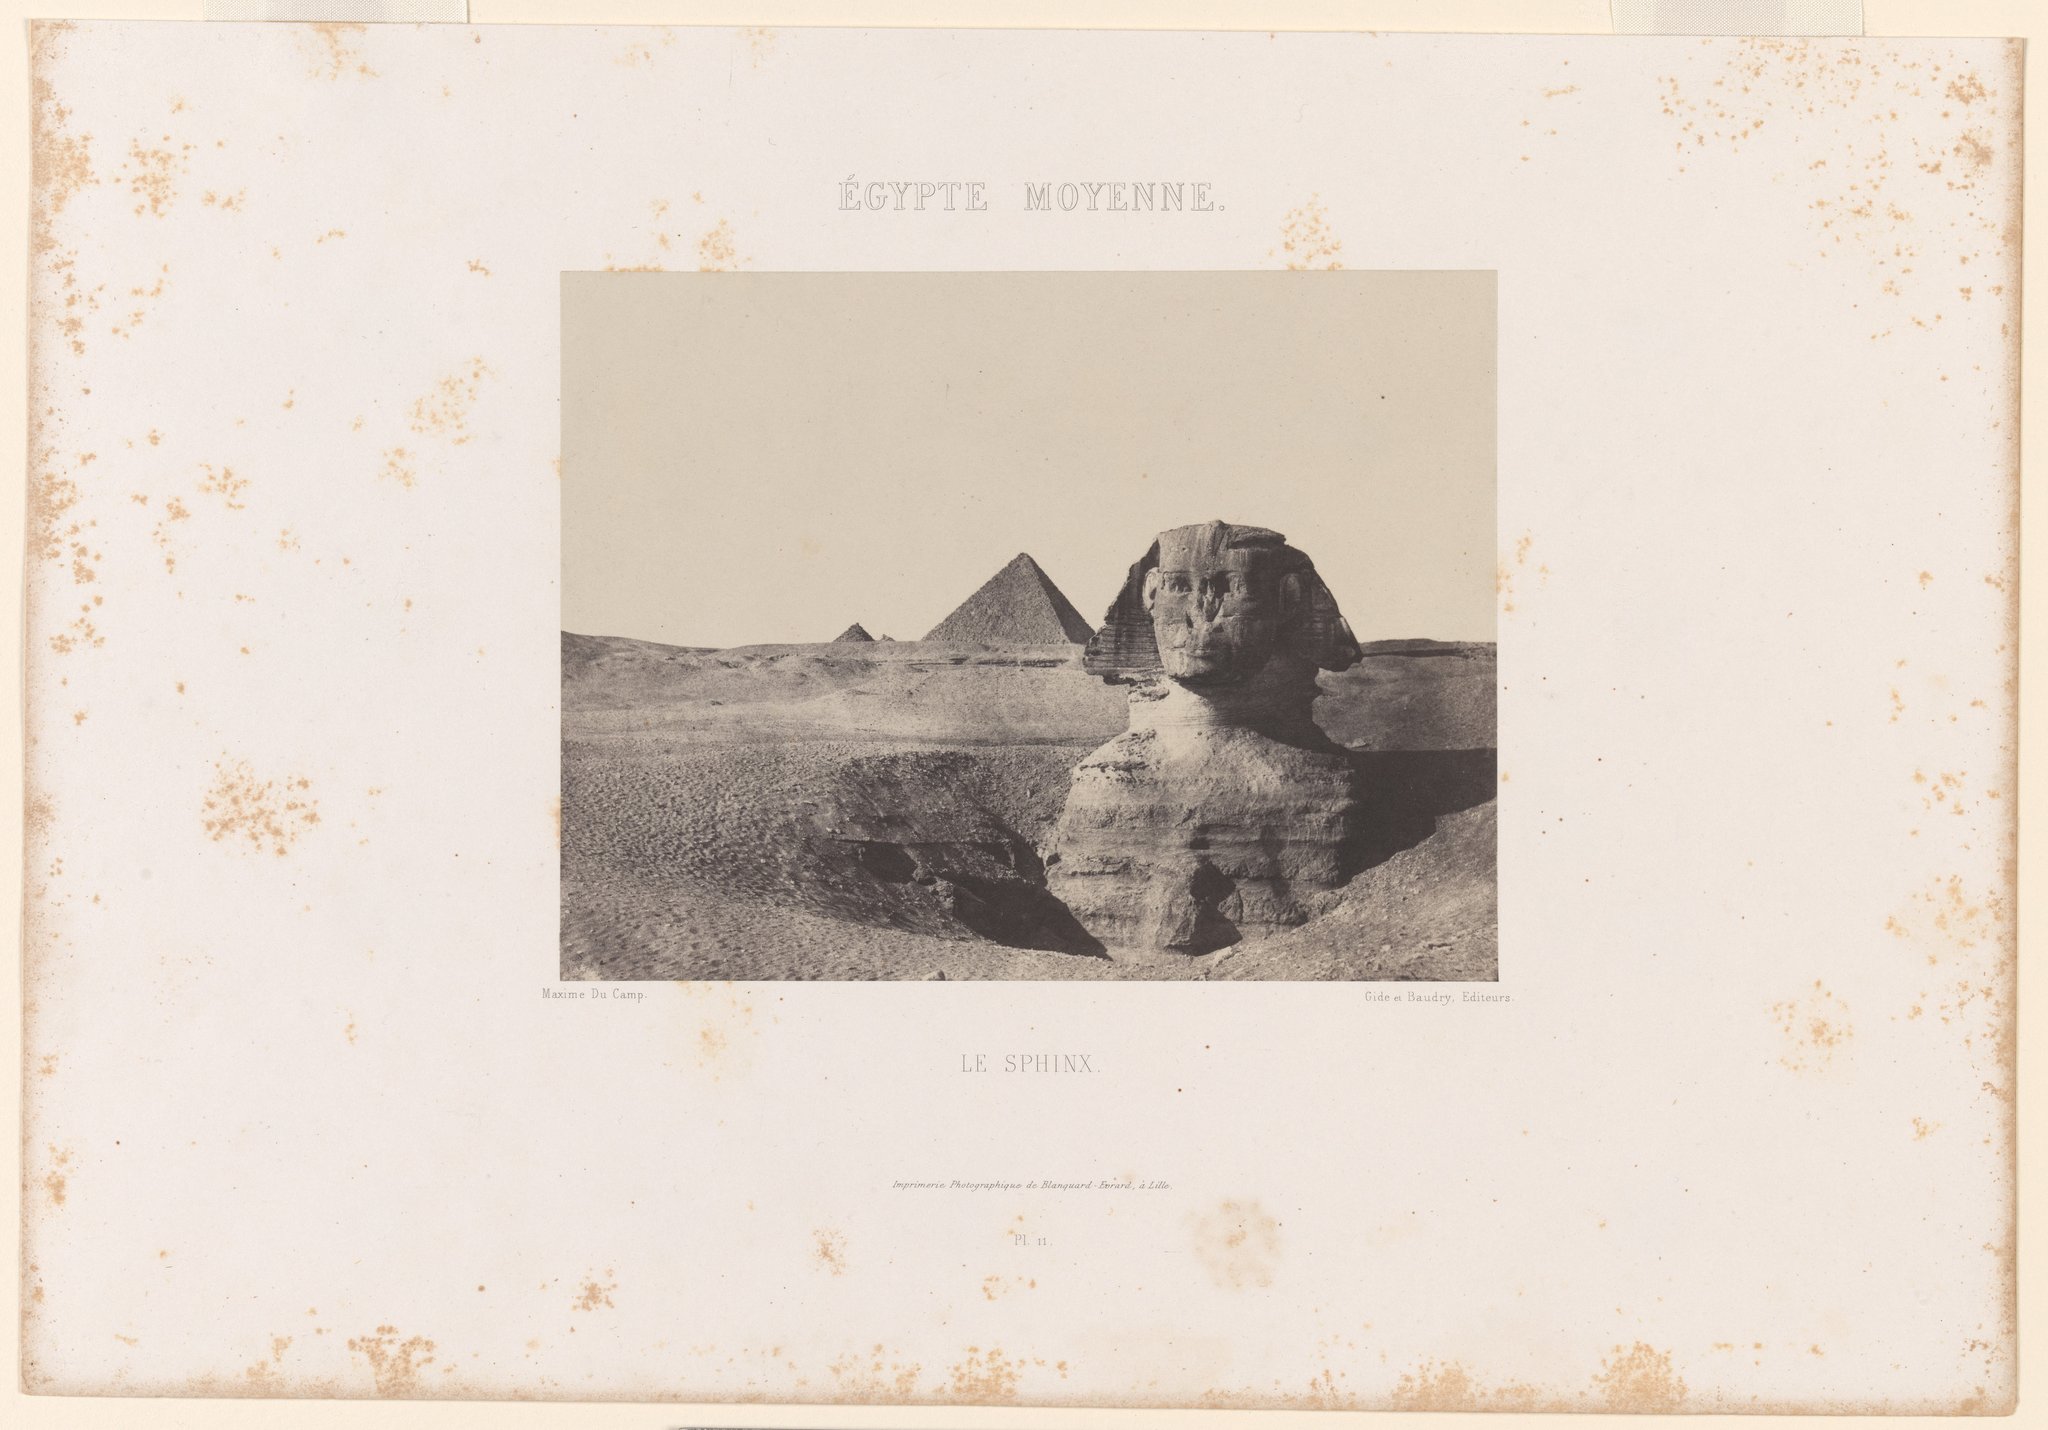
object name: photograph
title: Égypte Moyenne, Le Sphinx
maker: maxime du camp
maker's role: artist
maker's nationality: french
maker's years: 1822-1894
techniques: paper negative, salted paper print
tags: pyramids,sphinx